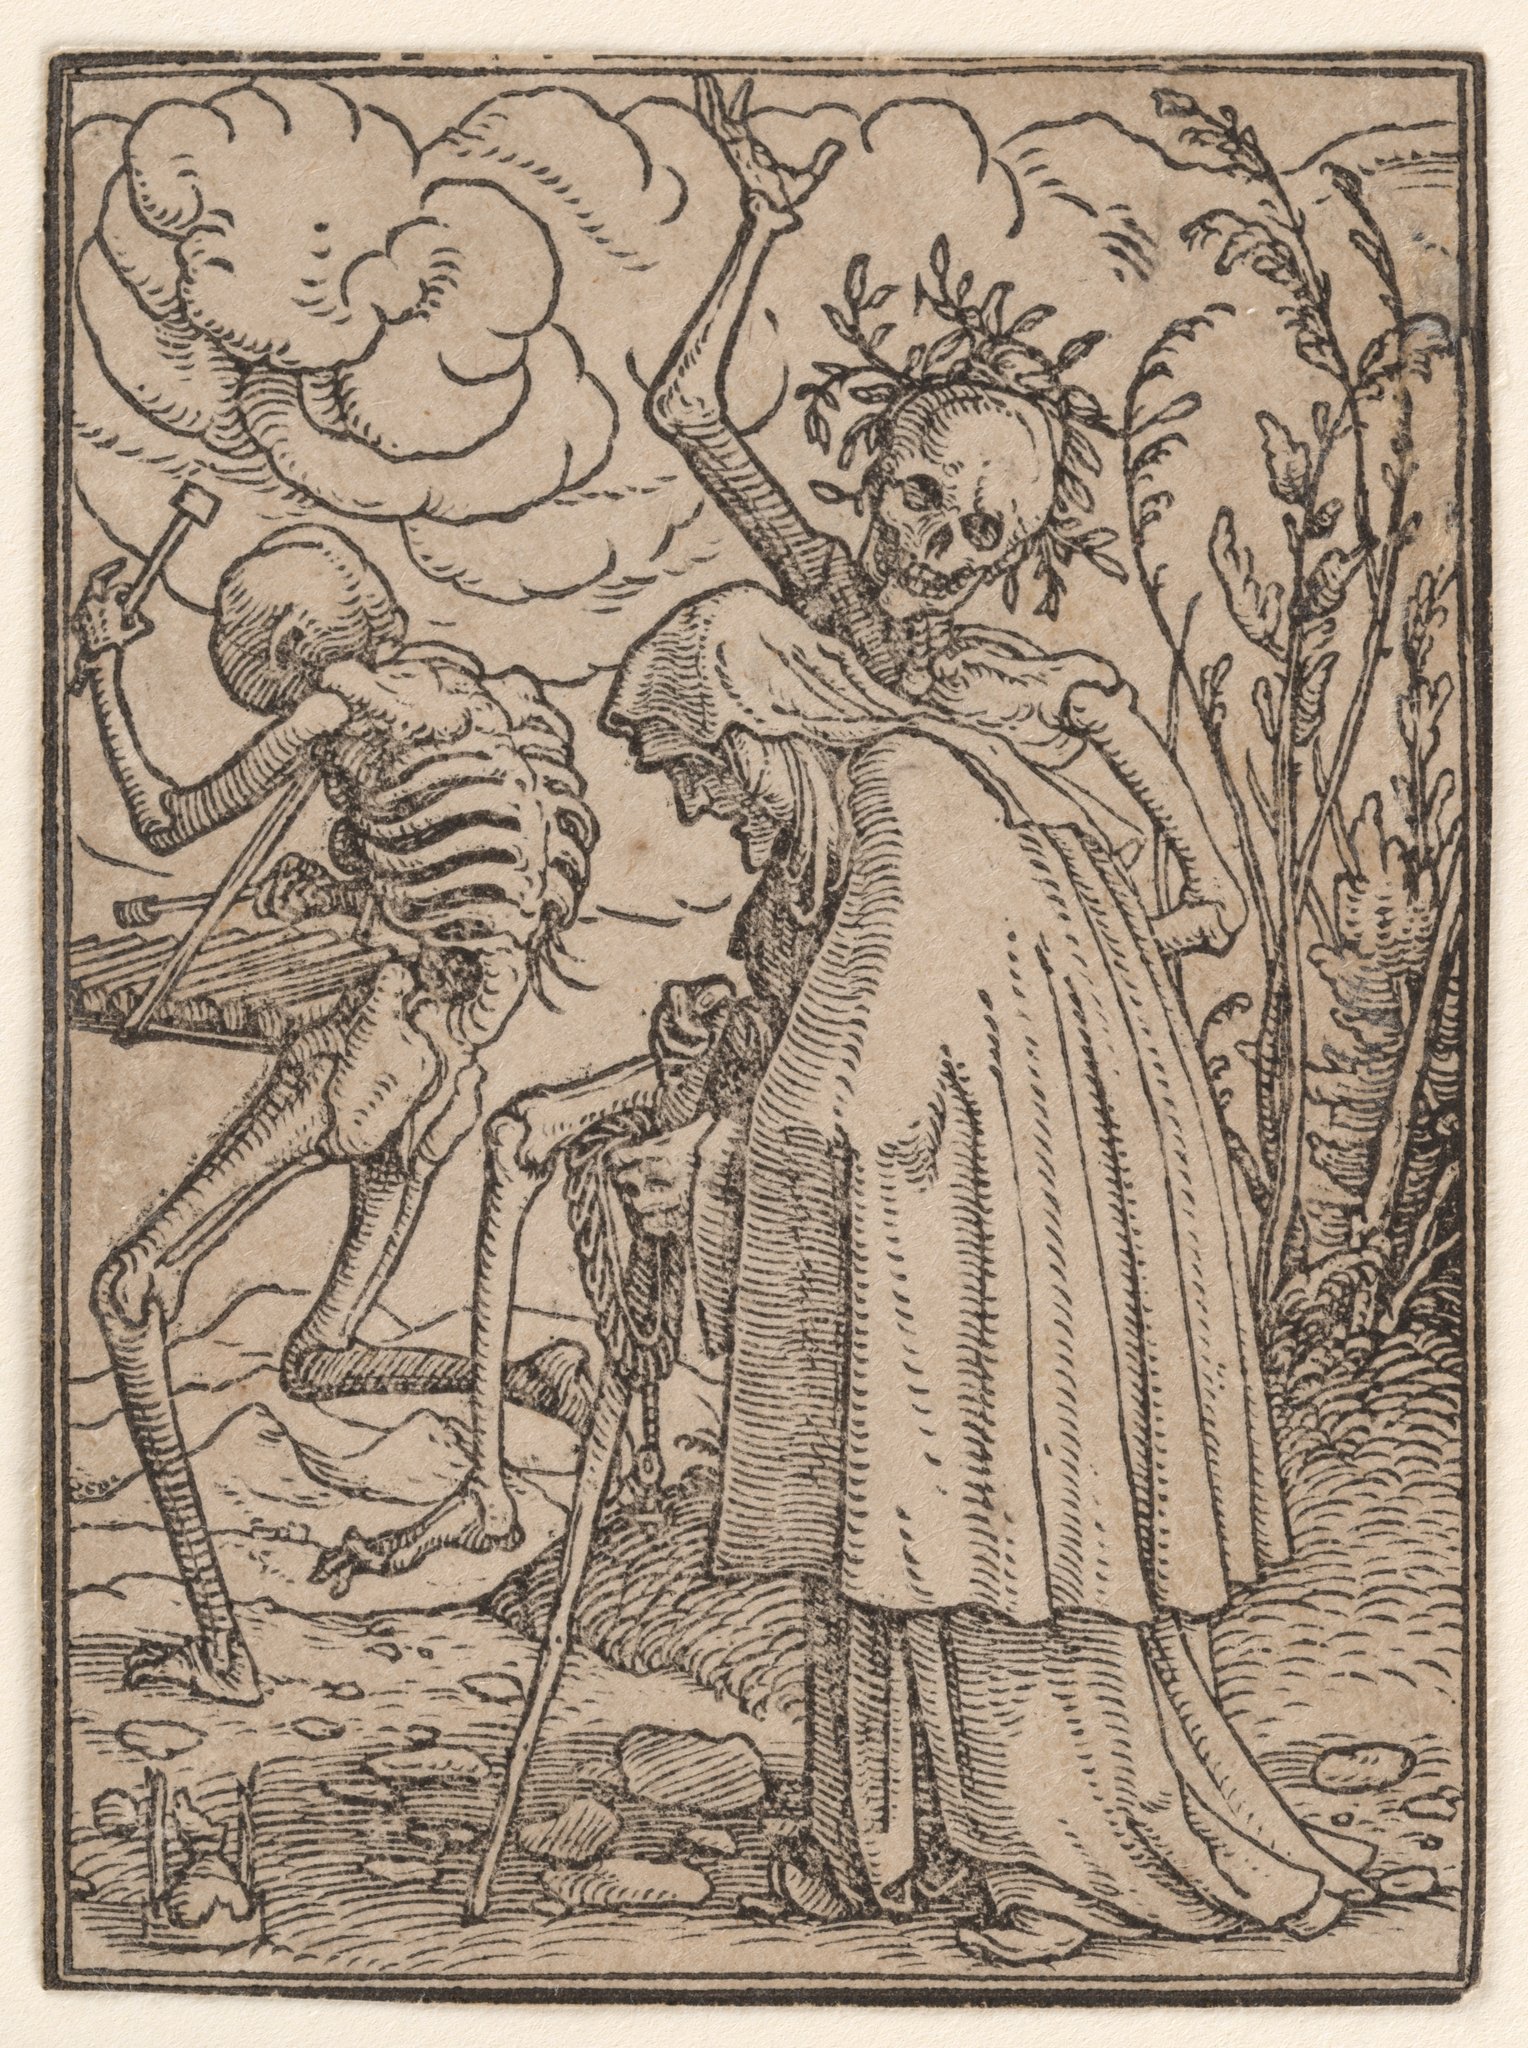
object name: print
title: The Old Woman, from "The Dance of Death"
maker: hans holbein the younger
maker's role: artist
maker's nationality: german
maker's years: 1497-1543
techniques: woodcut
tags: skeletons,women